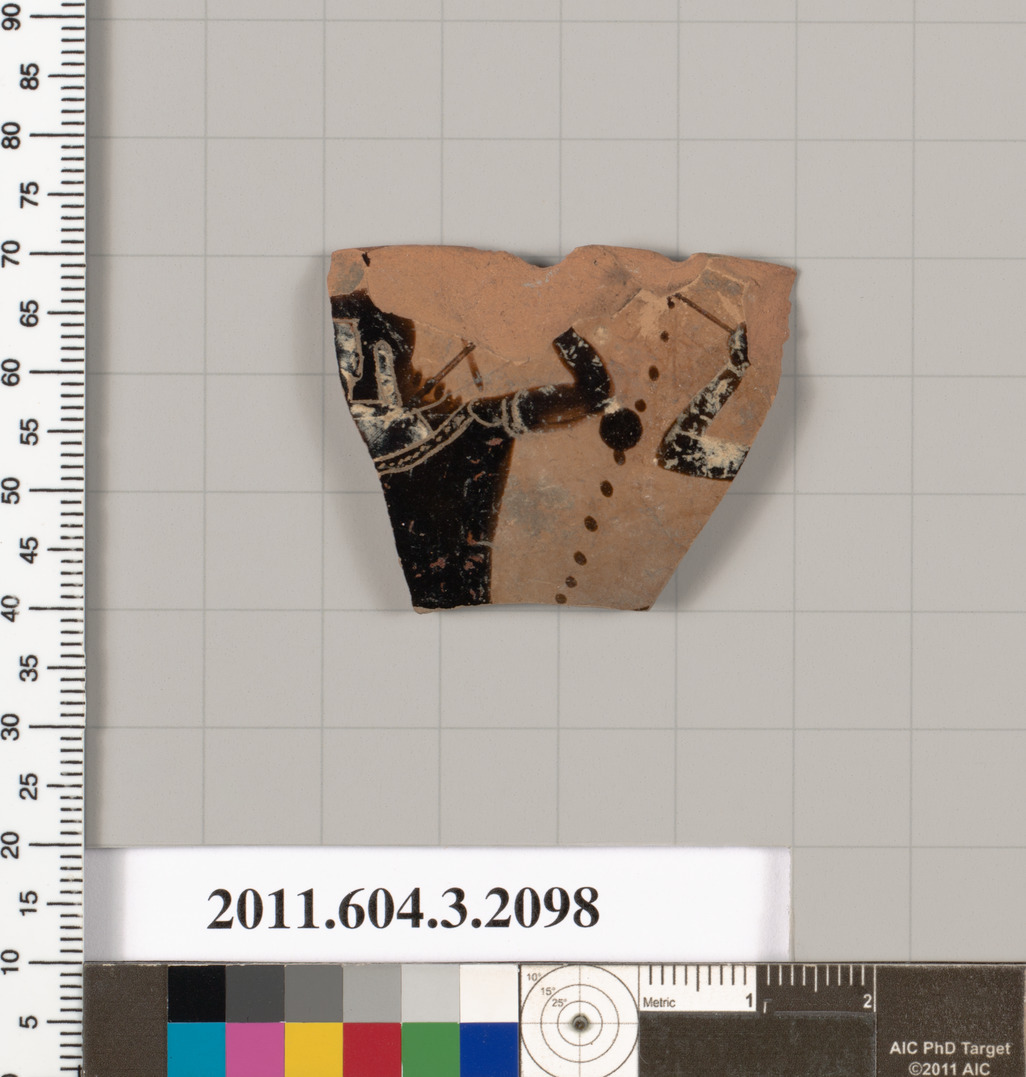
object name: kylix fragment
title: Terracotta fragment of a kylix (drinking cup)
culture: greek, attic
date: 534-501 BCE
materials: terracotta